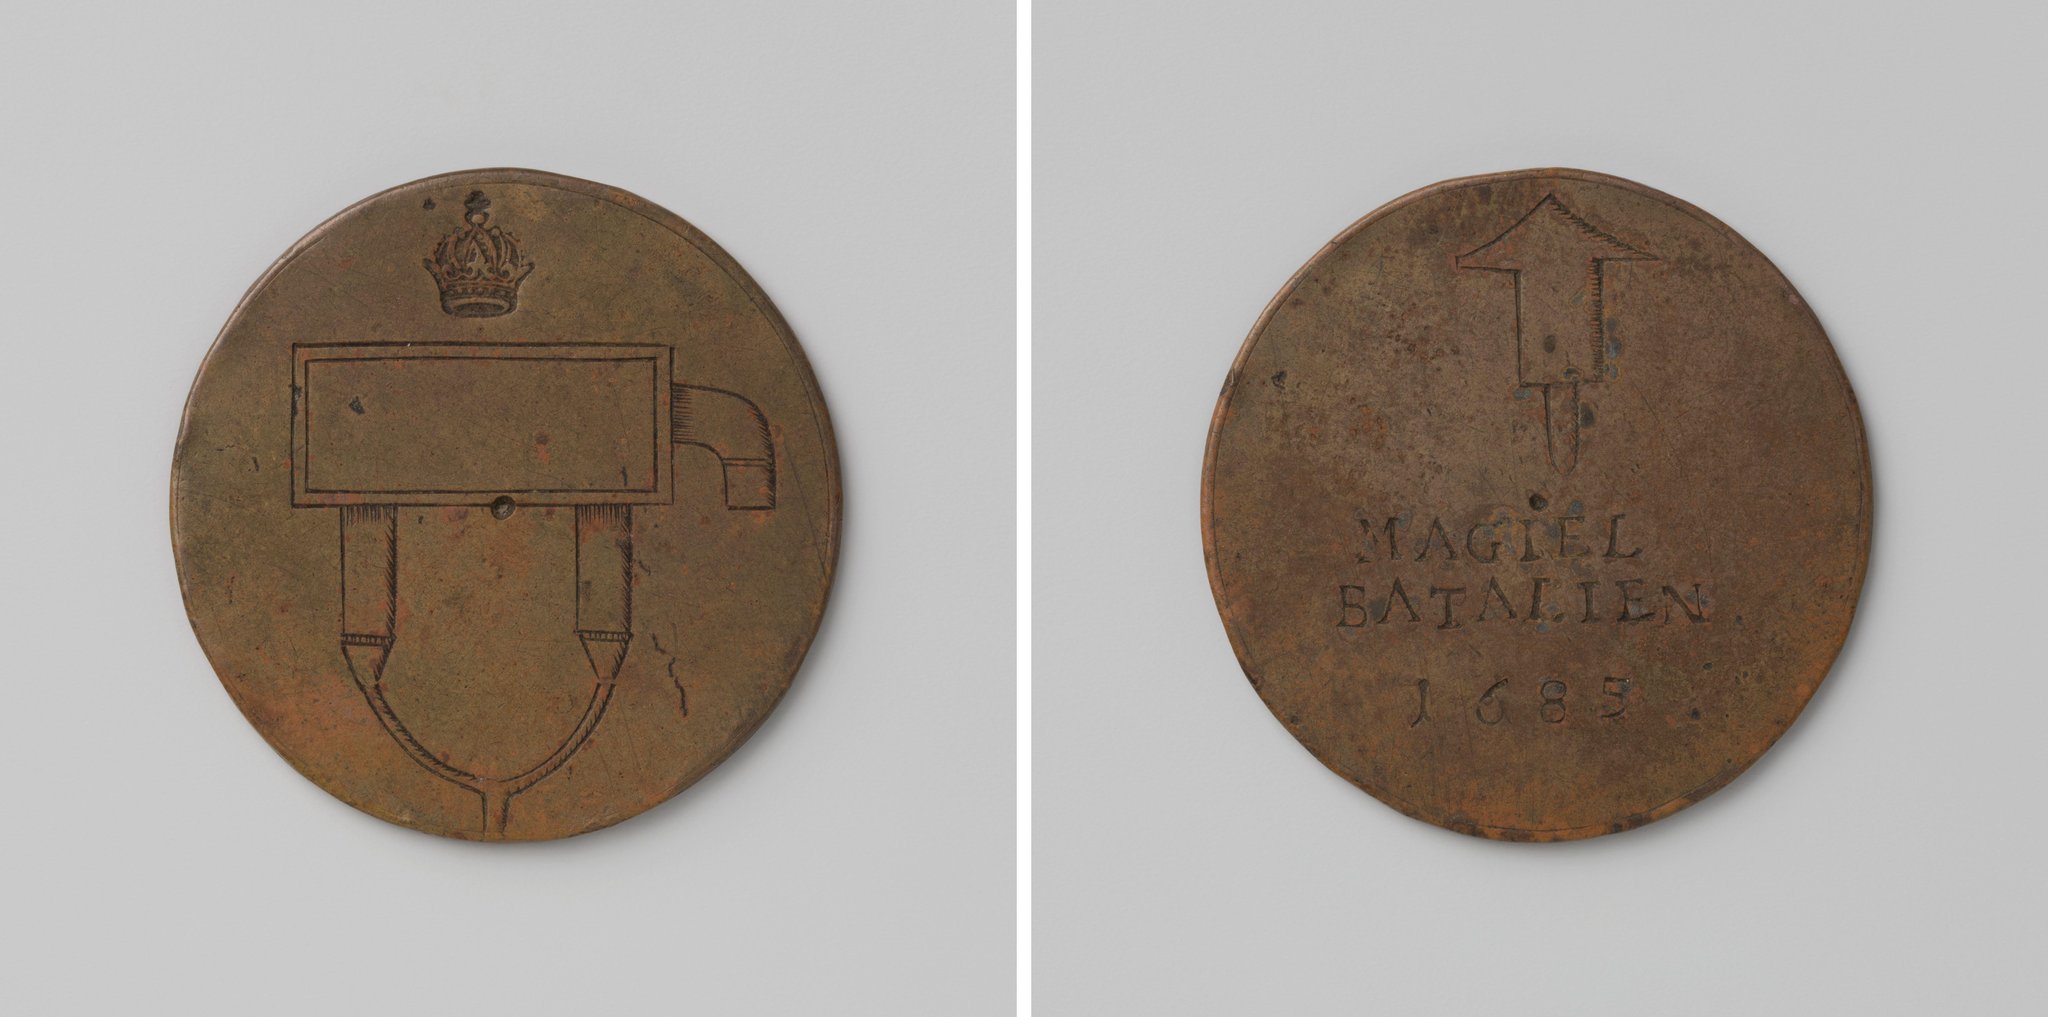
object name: medal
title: Metselaars-, steenhouwers-, leidekkers-, loodgieters- en pompenmakersgilde van Amsterdam, gildepenning van Magiel Batalien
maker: Anonymous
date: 1685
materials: brass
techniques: engraving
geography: amsterdam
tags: amsterdam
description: Messing penning. Voorzijde: pomp onder kroon. Keerzijde: loodgietershamer boven opschrift en jaartal